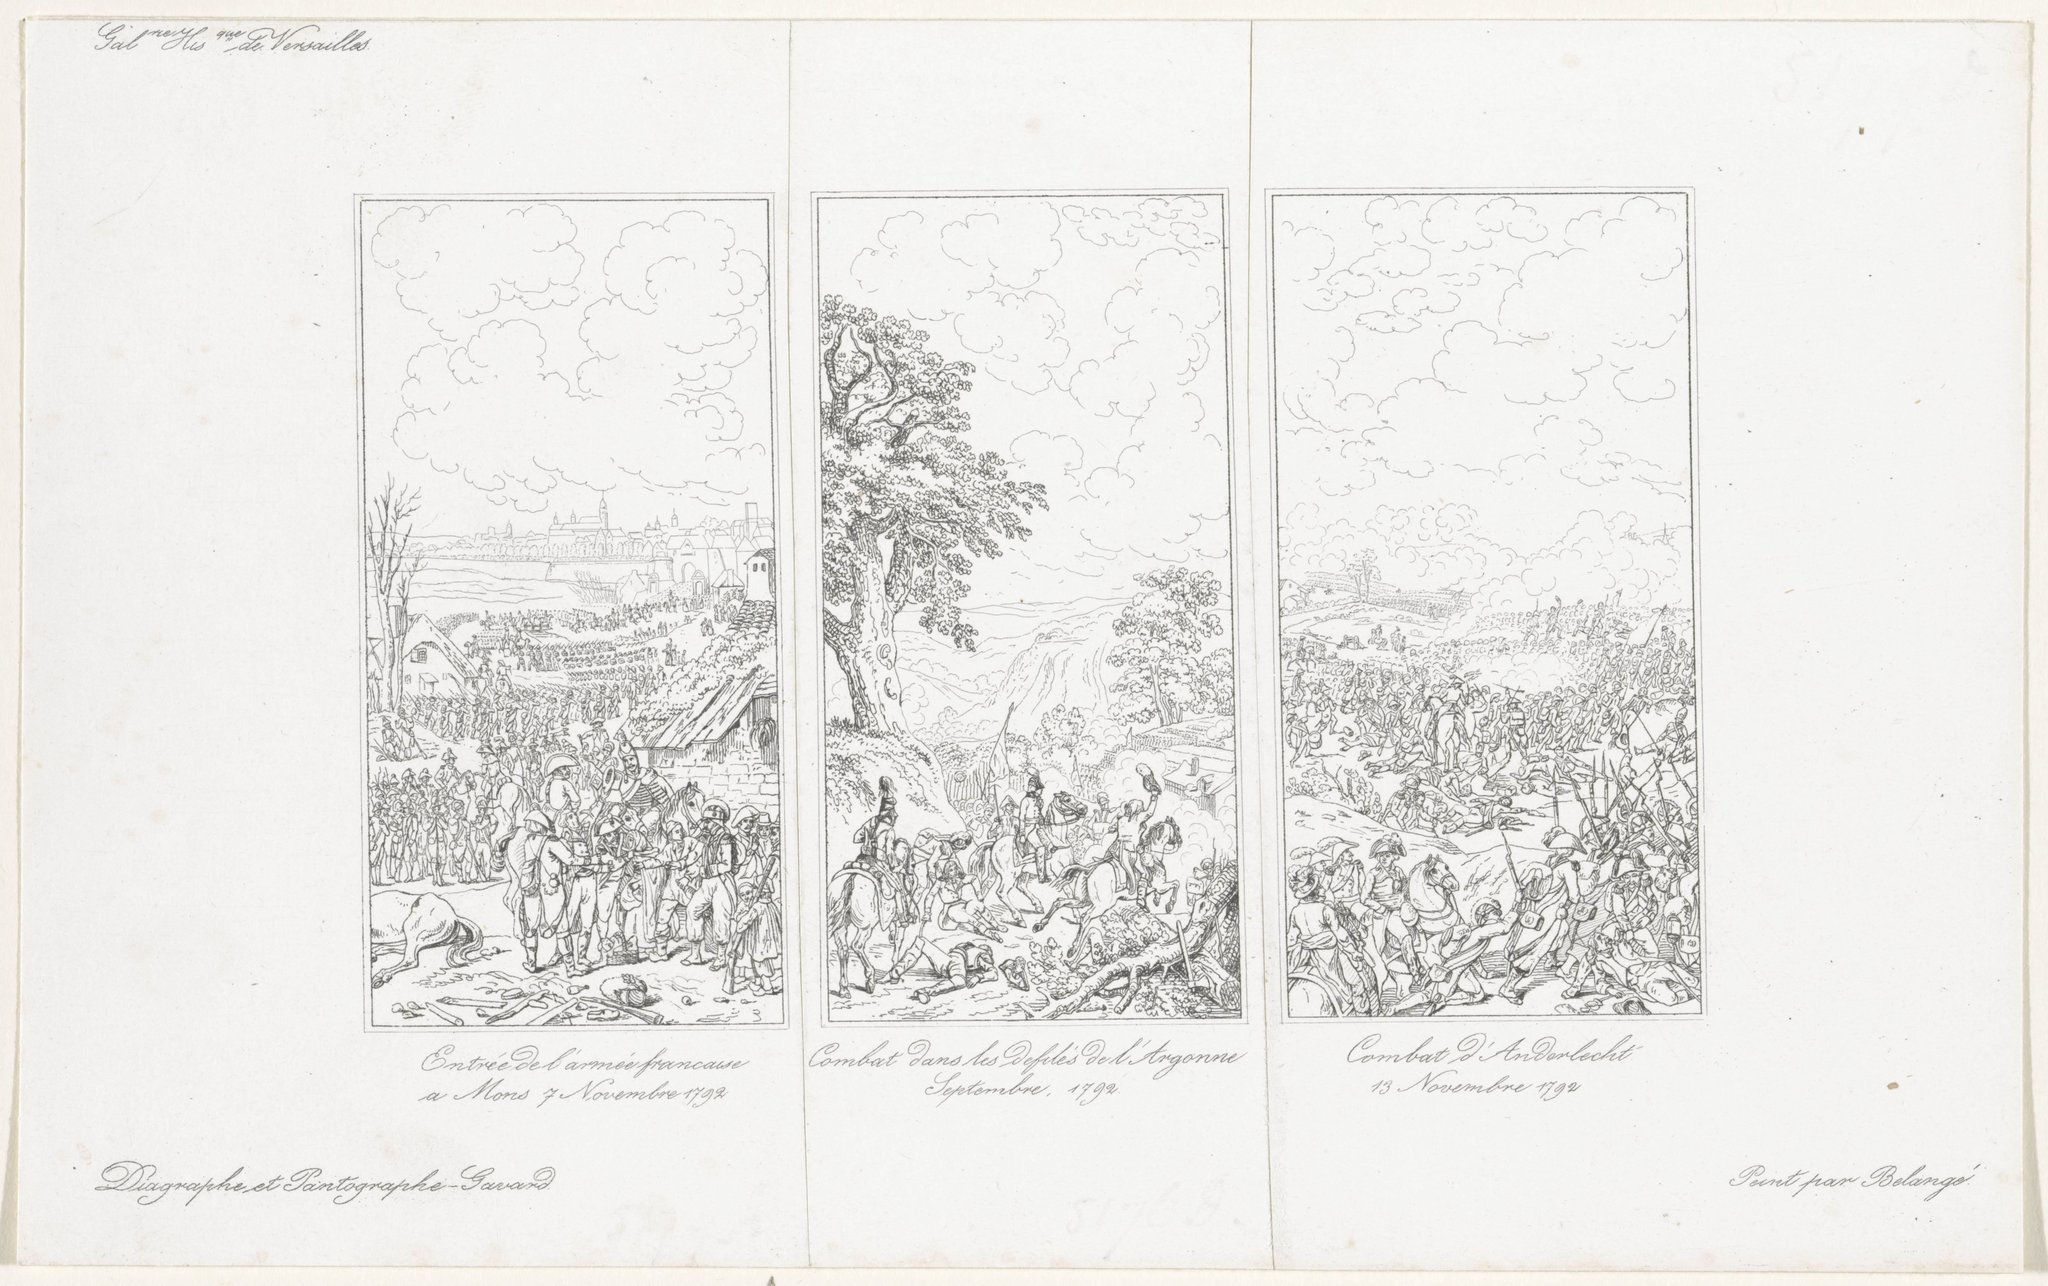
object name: print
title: Entrée de l'armée francaise a Mons 7 Novembre 1792 / Combat dans les Defilés de l'Argonne Septembre 1792 / Combat d'Anderlecht 19 Novembre 1792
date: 1835-1840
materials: paper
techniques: etching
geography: france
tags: battle (+ land forces)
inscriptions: collector's mark: Lugt 2228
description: Niet in Frederik Muller; door het RPK toegevoegd nummer. Gebruikt als illustratie in: C. Gavard, Galeries historiques de Versailles, collection de gravures réduites d'après les dessins originaux du grand ouvrage, Parijs 1840. Op de prent vermeld: Diagraphe et Pantographe Gavard.